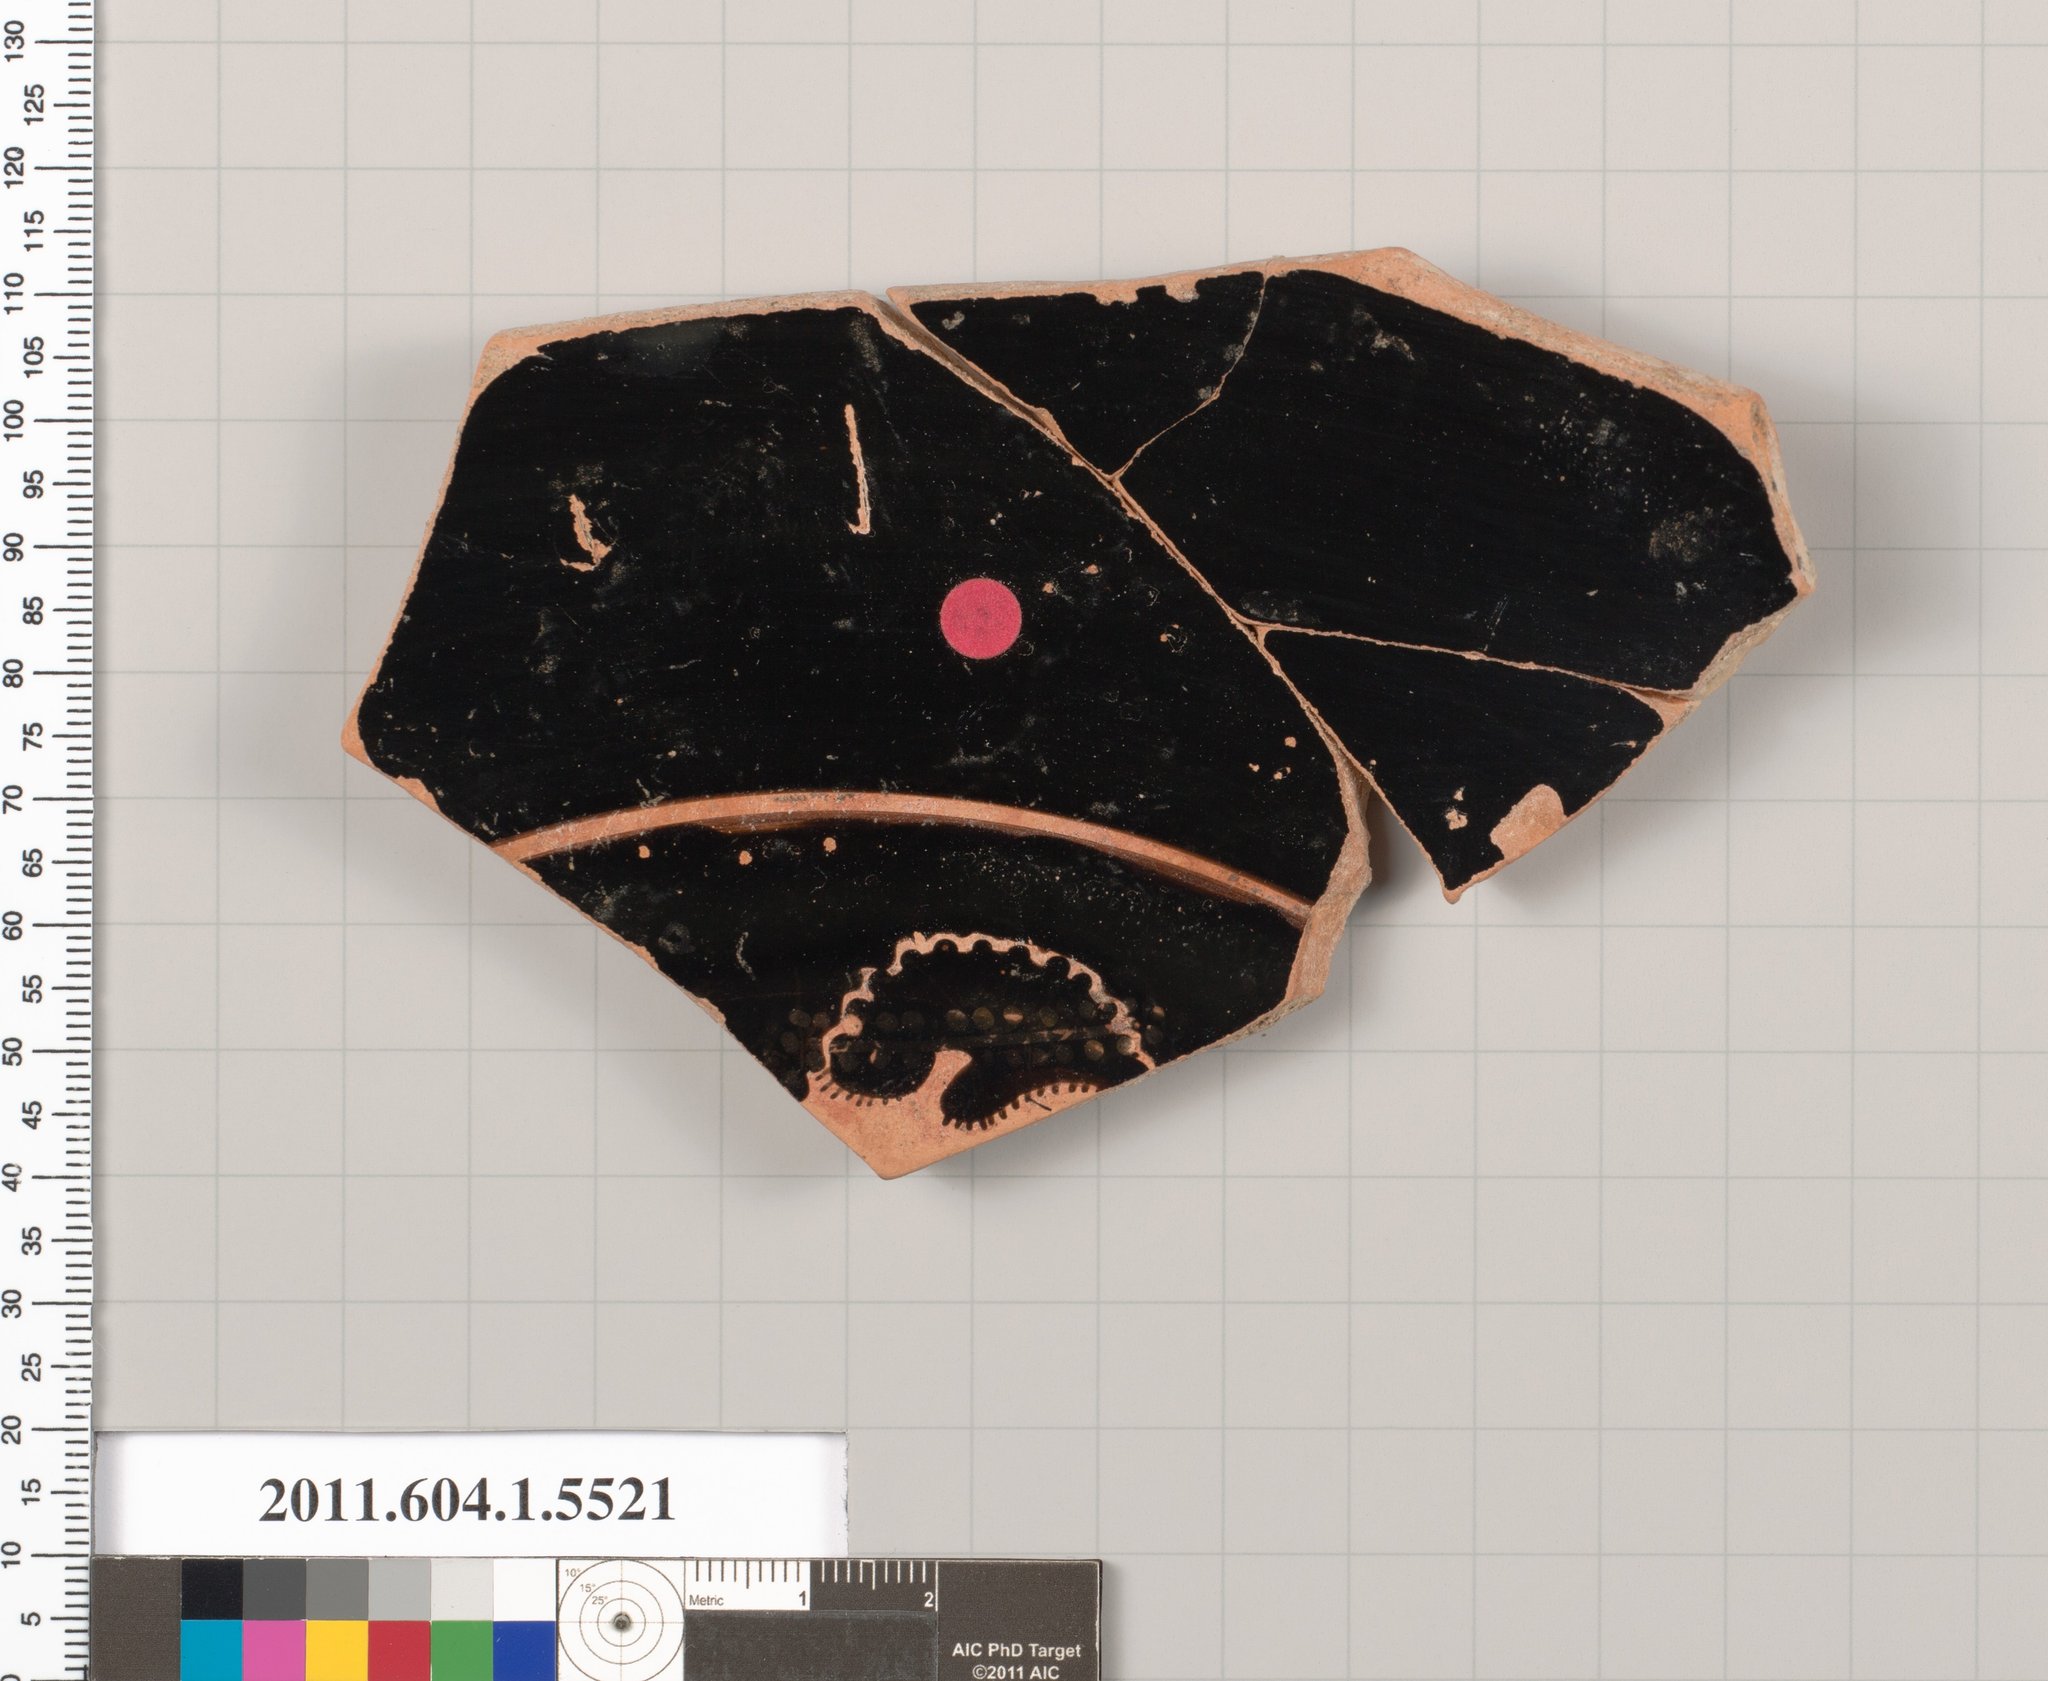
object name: kylix fragment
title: Terracotta fragment of a kylix (drinking cup)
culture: greek, attic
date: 520-510 BCE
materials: terracotta